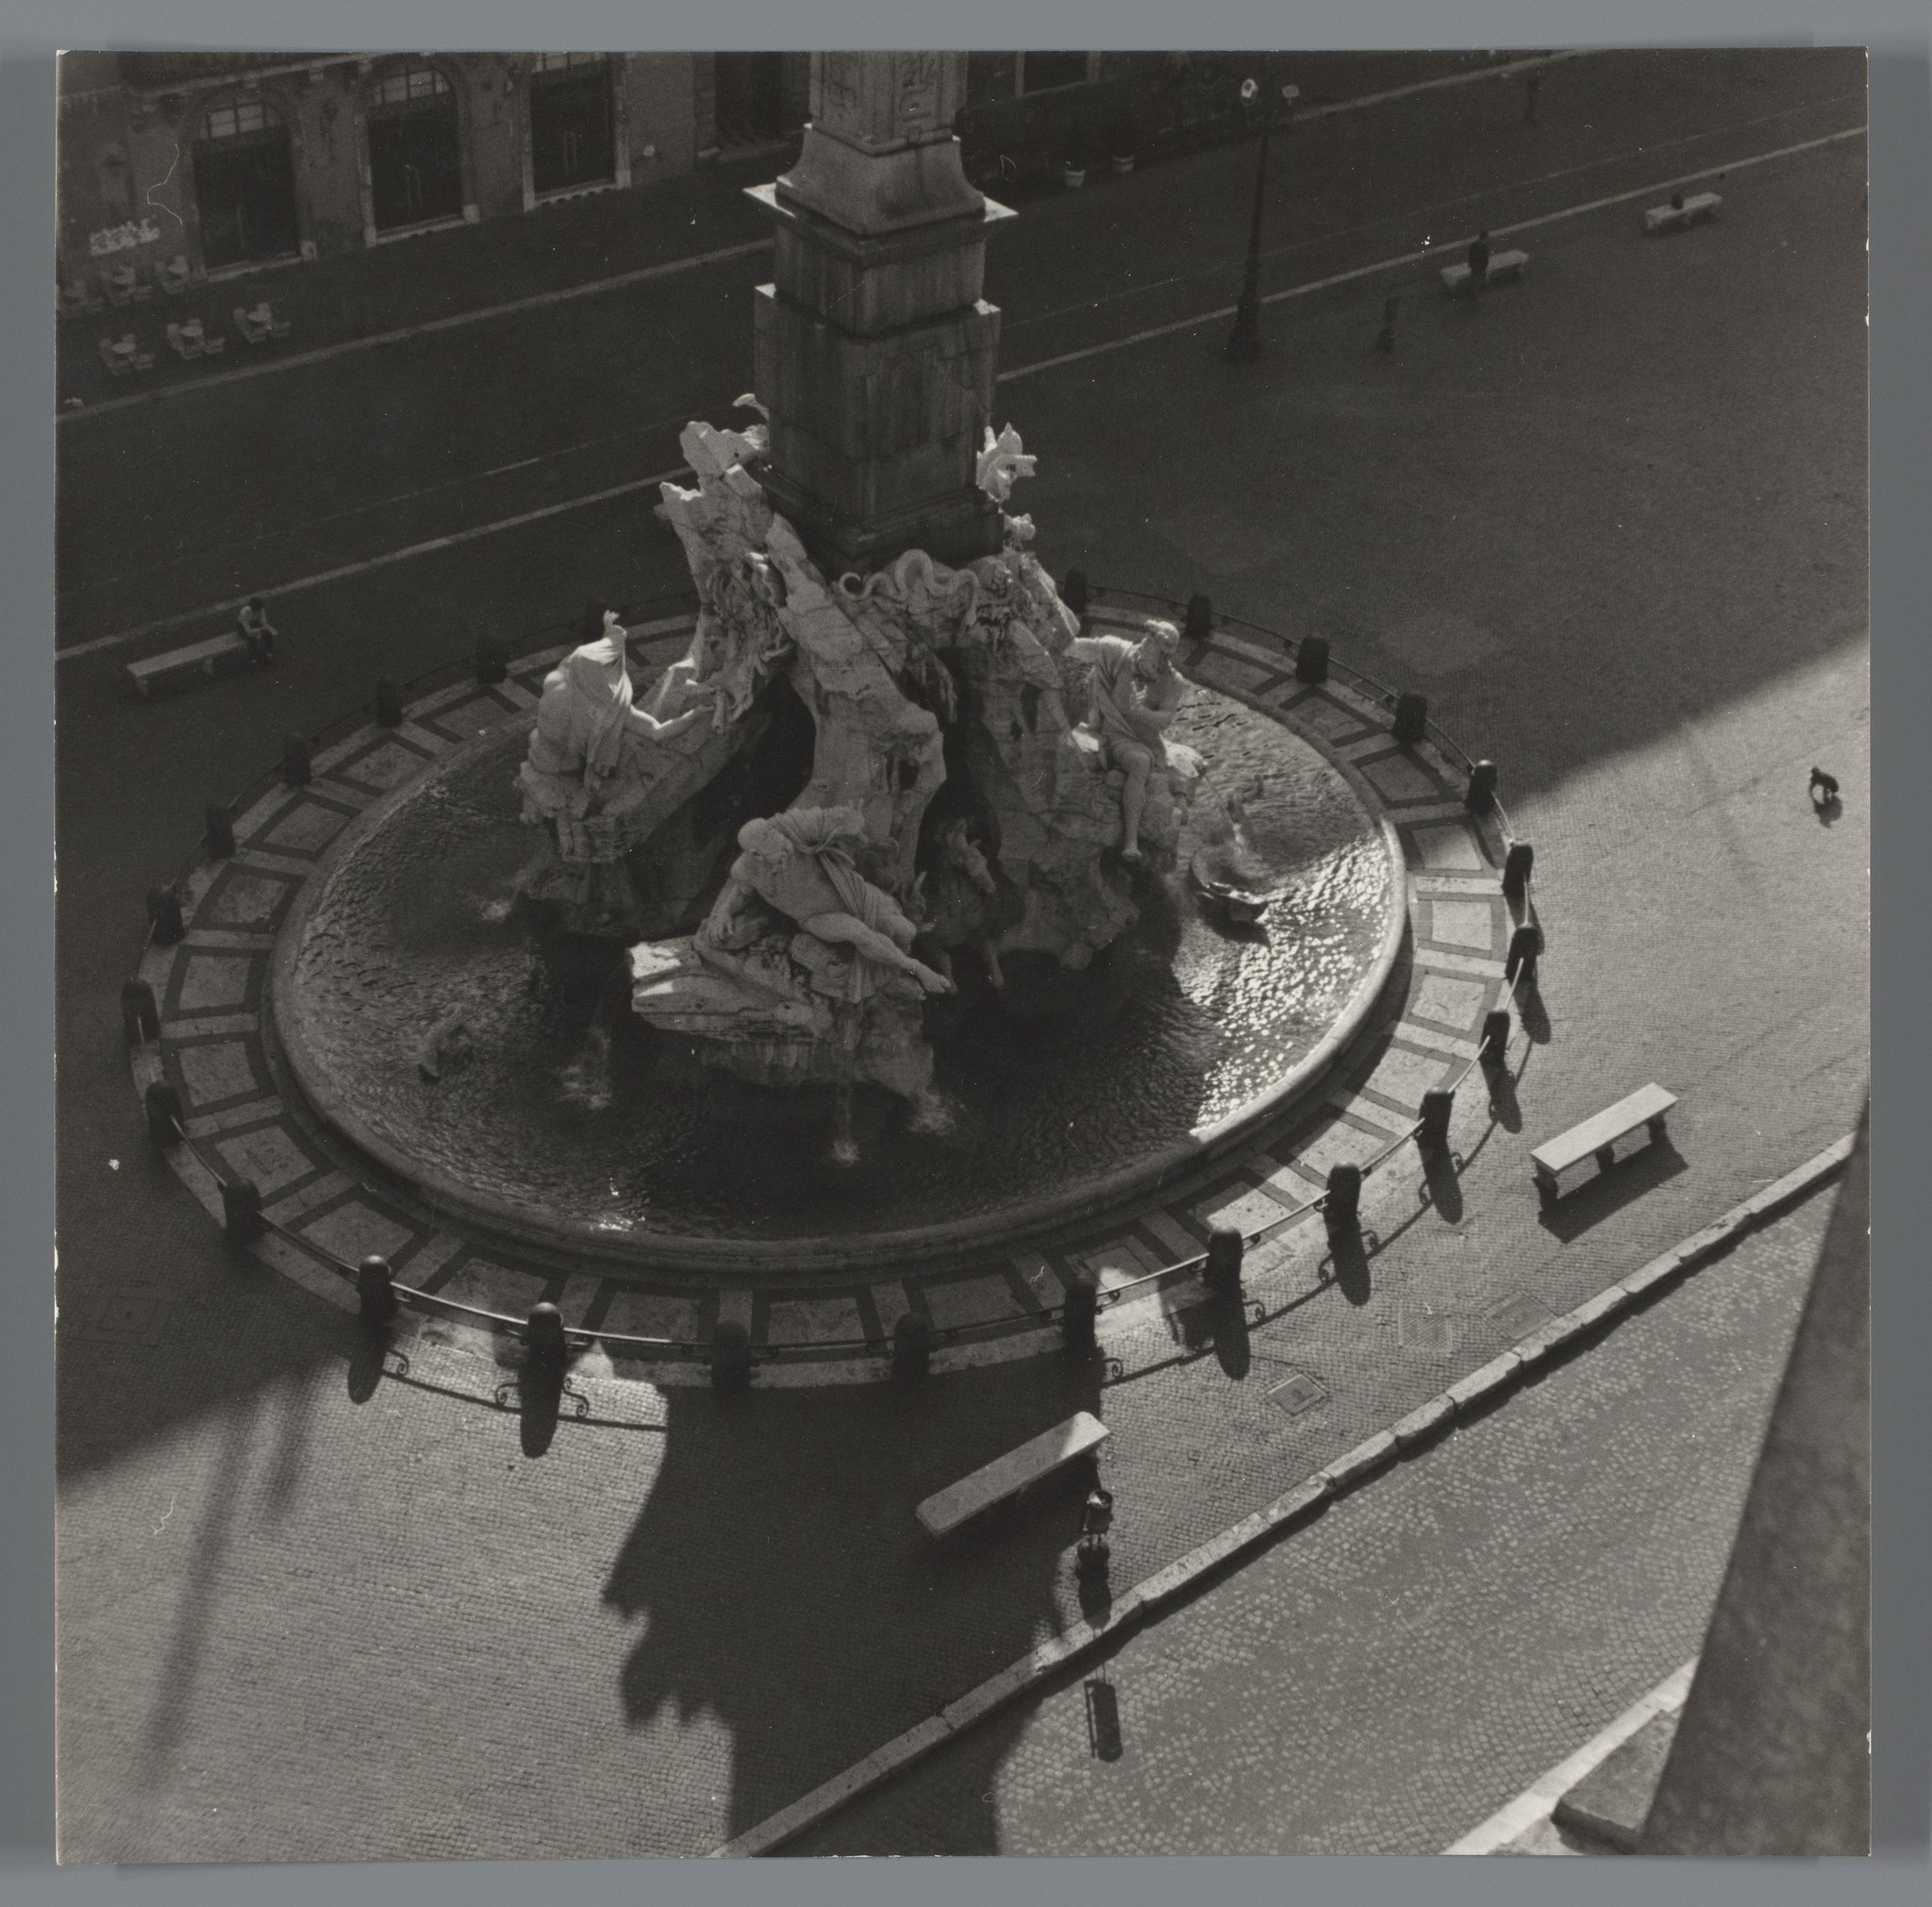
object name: photograph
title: Italië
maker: Anonymous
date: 1880-1910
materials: photographic support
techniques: albumen print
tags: italy